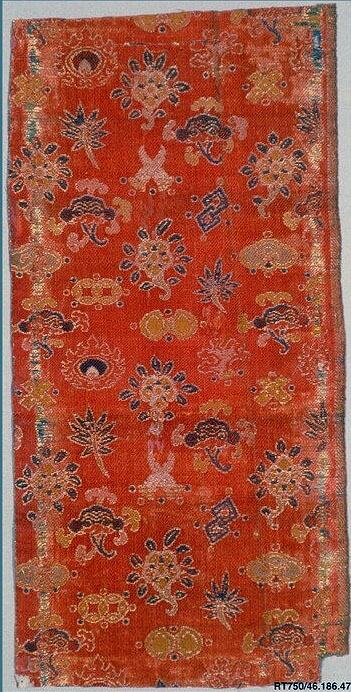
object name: sutra cover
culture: chinese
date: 1601-1700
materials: metal thread, silk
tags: flowers